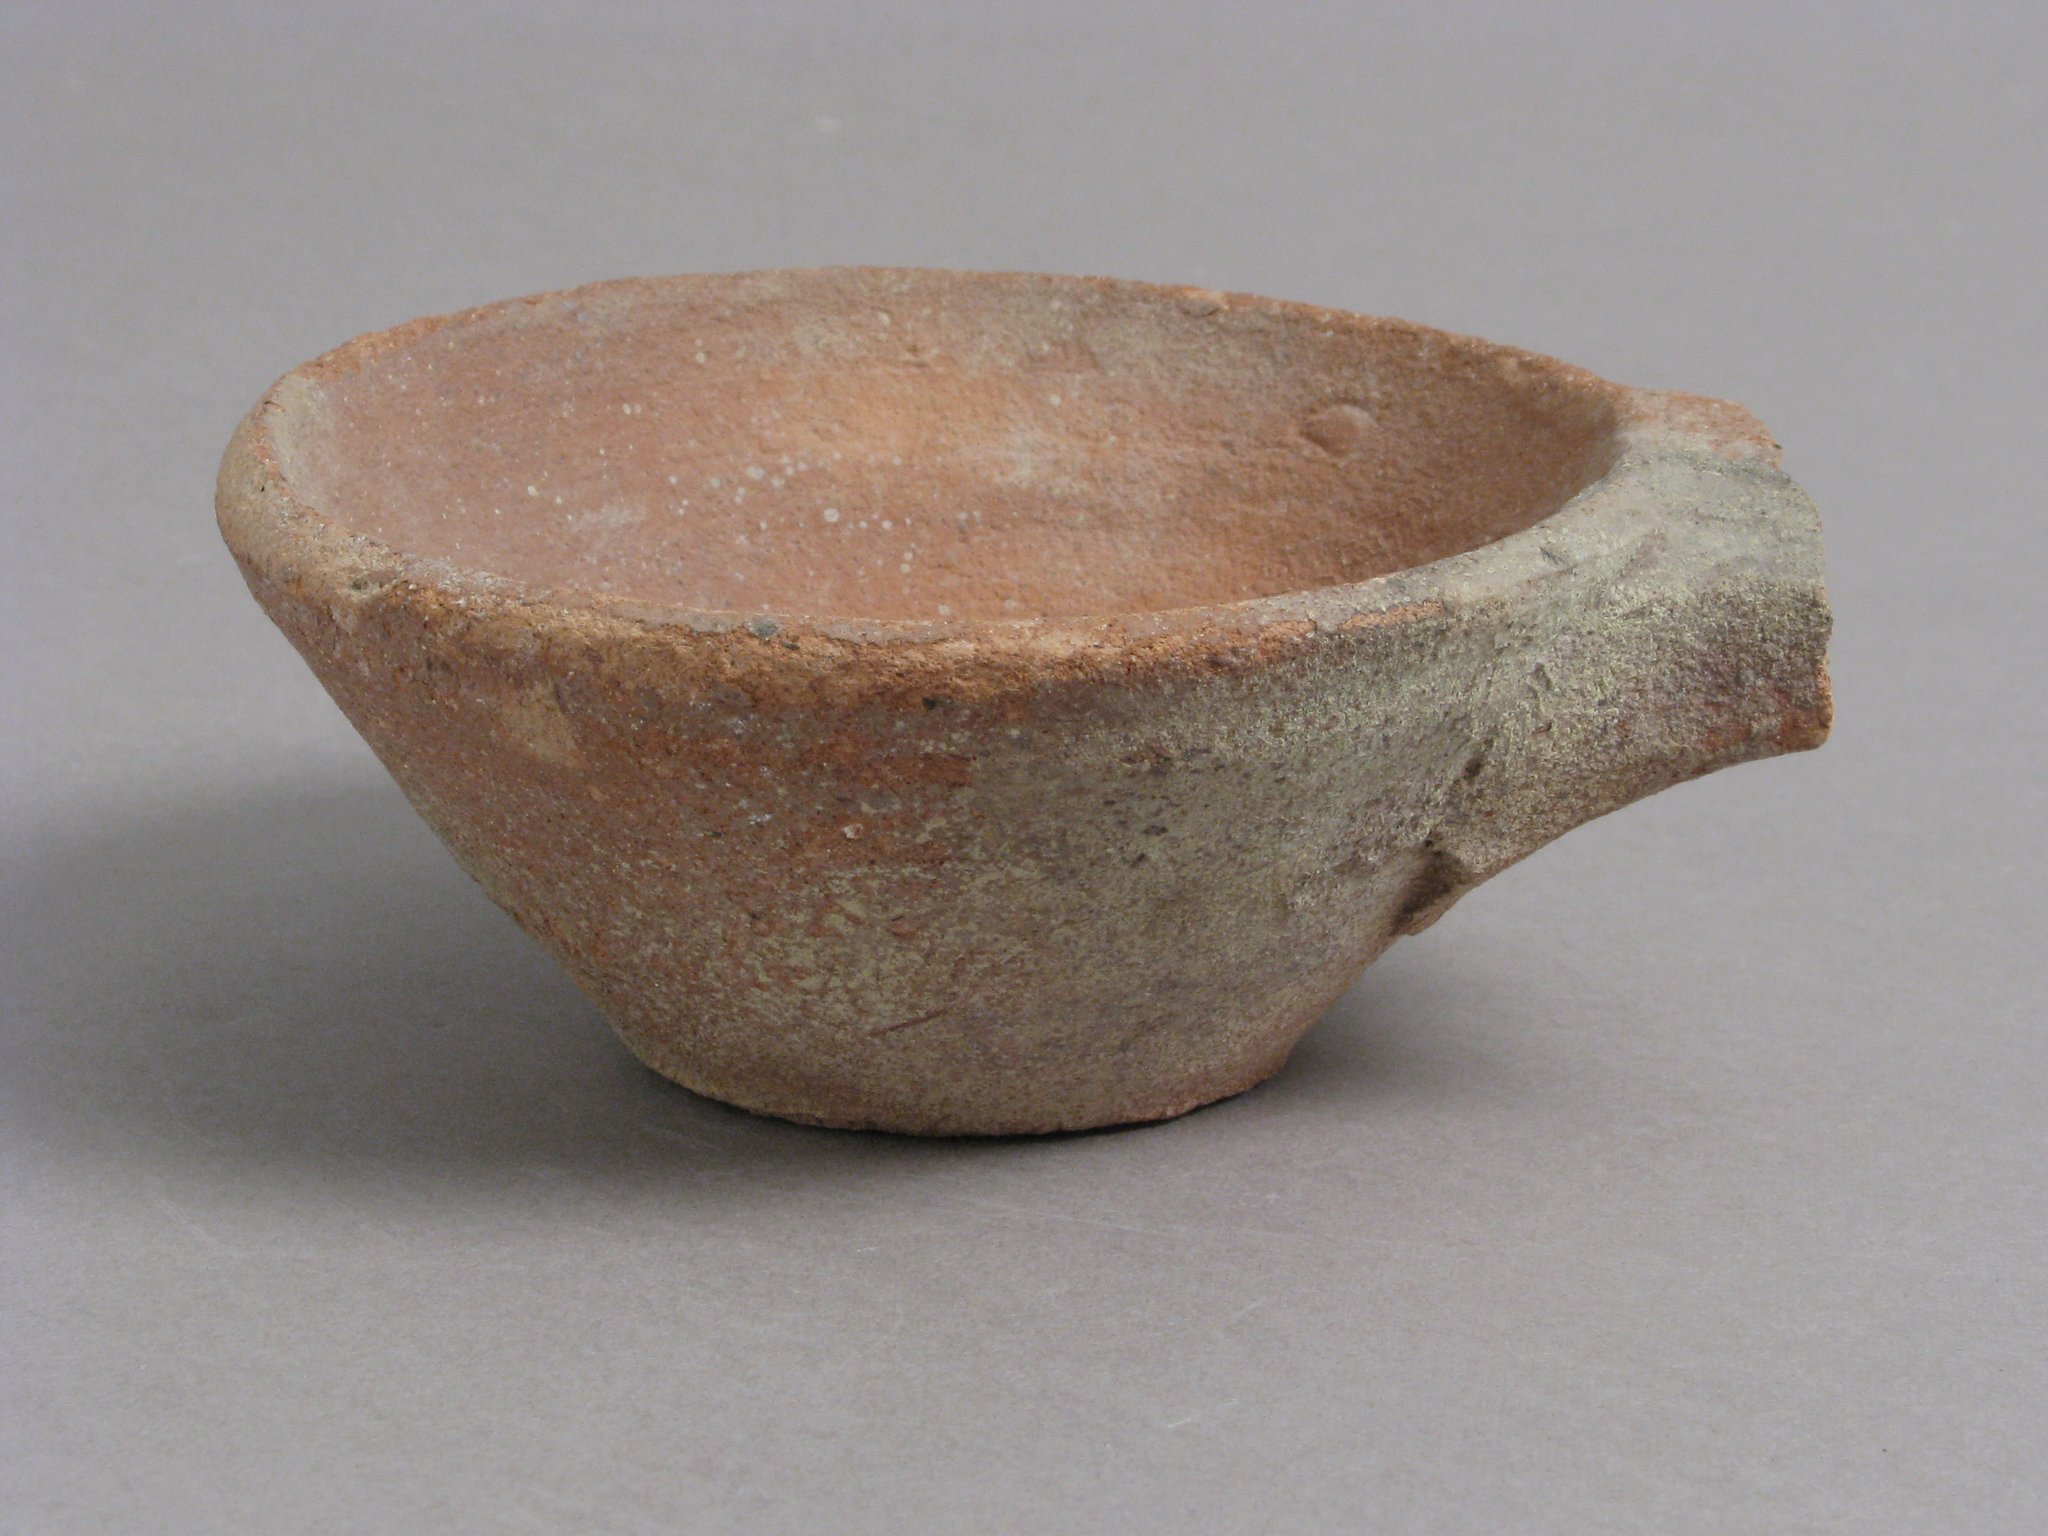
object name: bowl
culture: coptic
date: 301-700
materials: earthenware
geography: egypt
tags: bowls